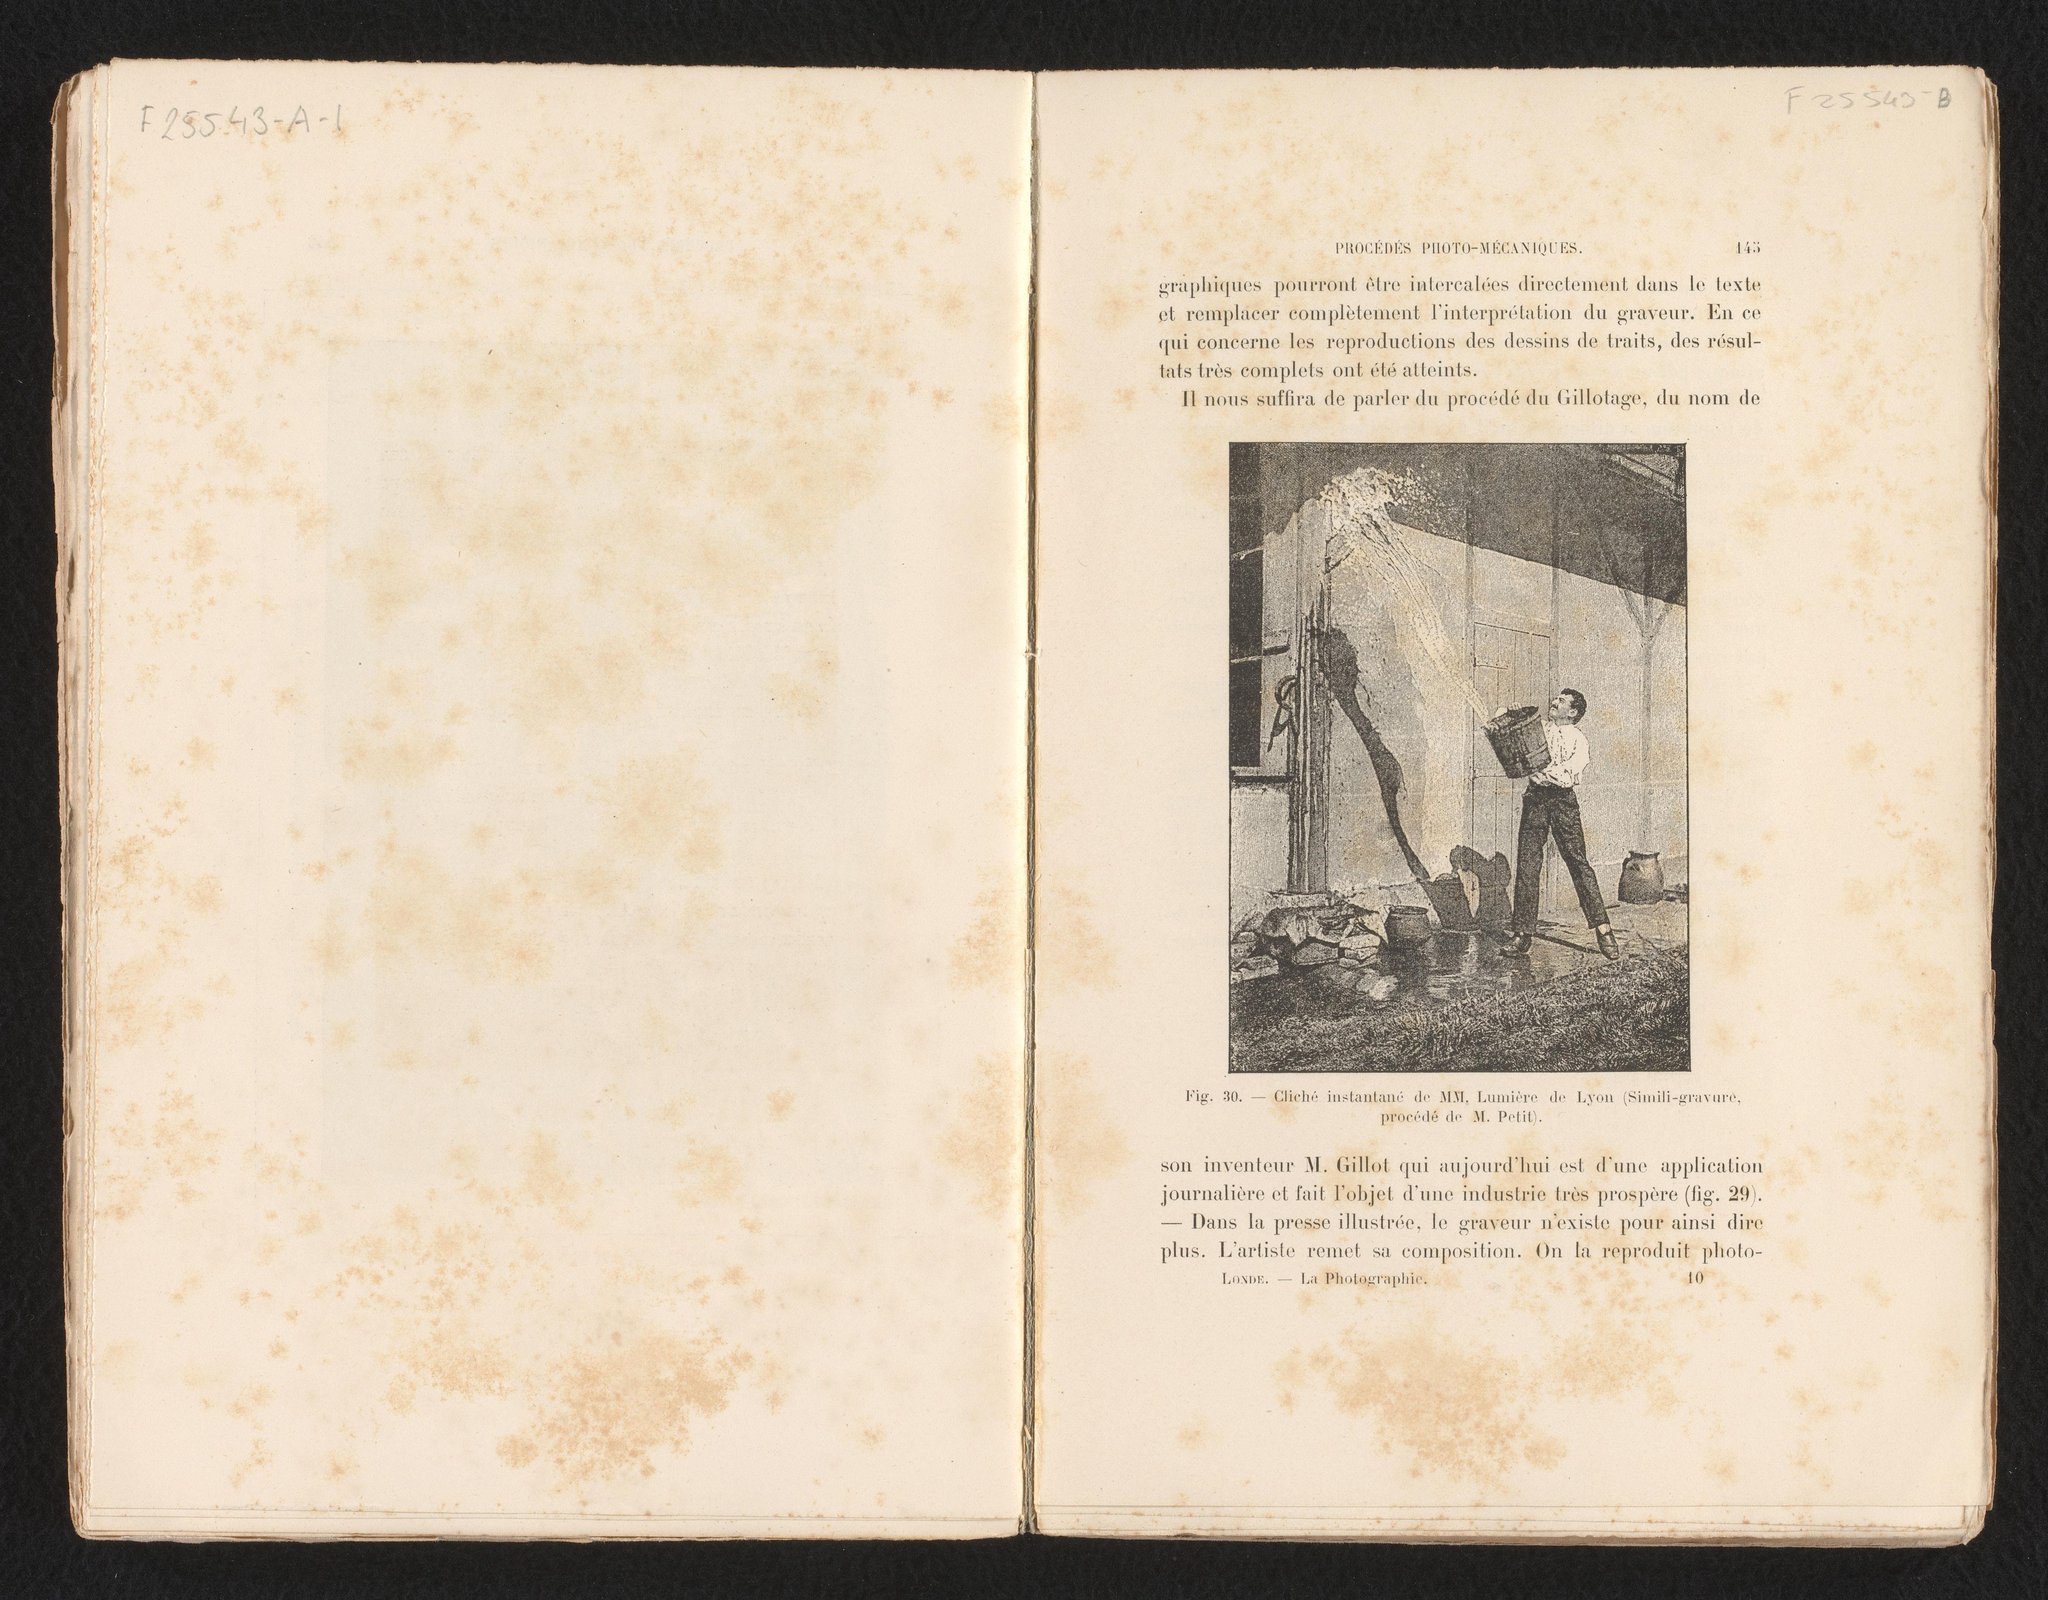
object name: page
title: Man gooit emmer water tegen een muur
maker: charles g. petit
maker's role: fotograaf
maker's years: -1921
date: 1883-1888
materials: paper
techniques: autotype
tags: wooden container: barrel, cask, bucket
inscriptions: inscription: ‘Fig. 30. - Cliché instantané de MM. Lumière de Lyon (Simili-gravure,/ procédé de M. Petit).’